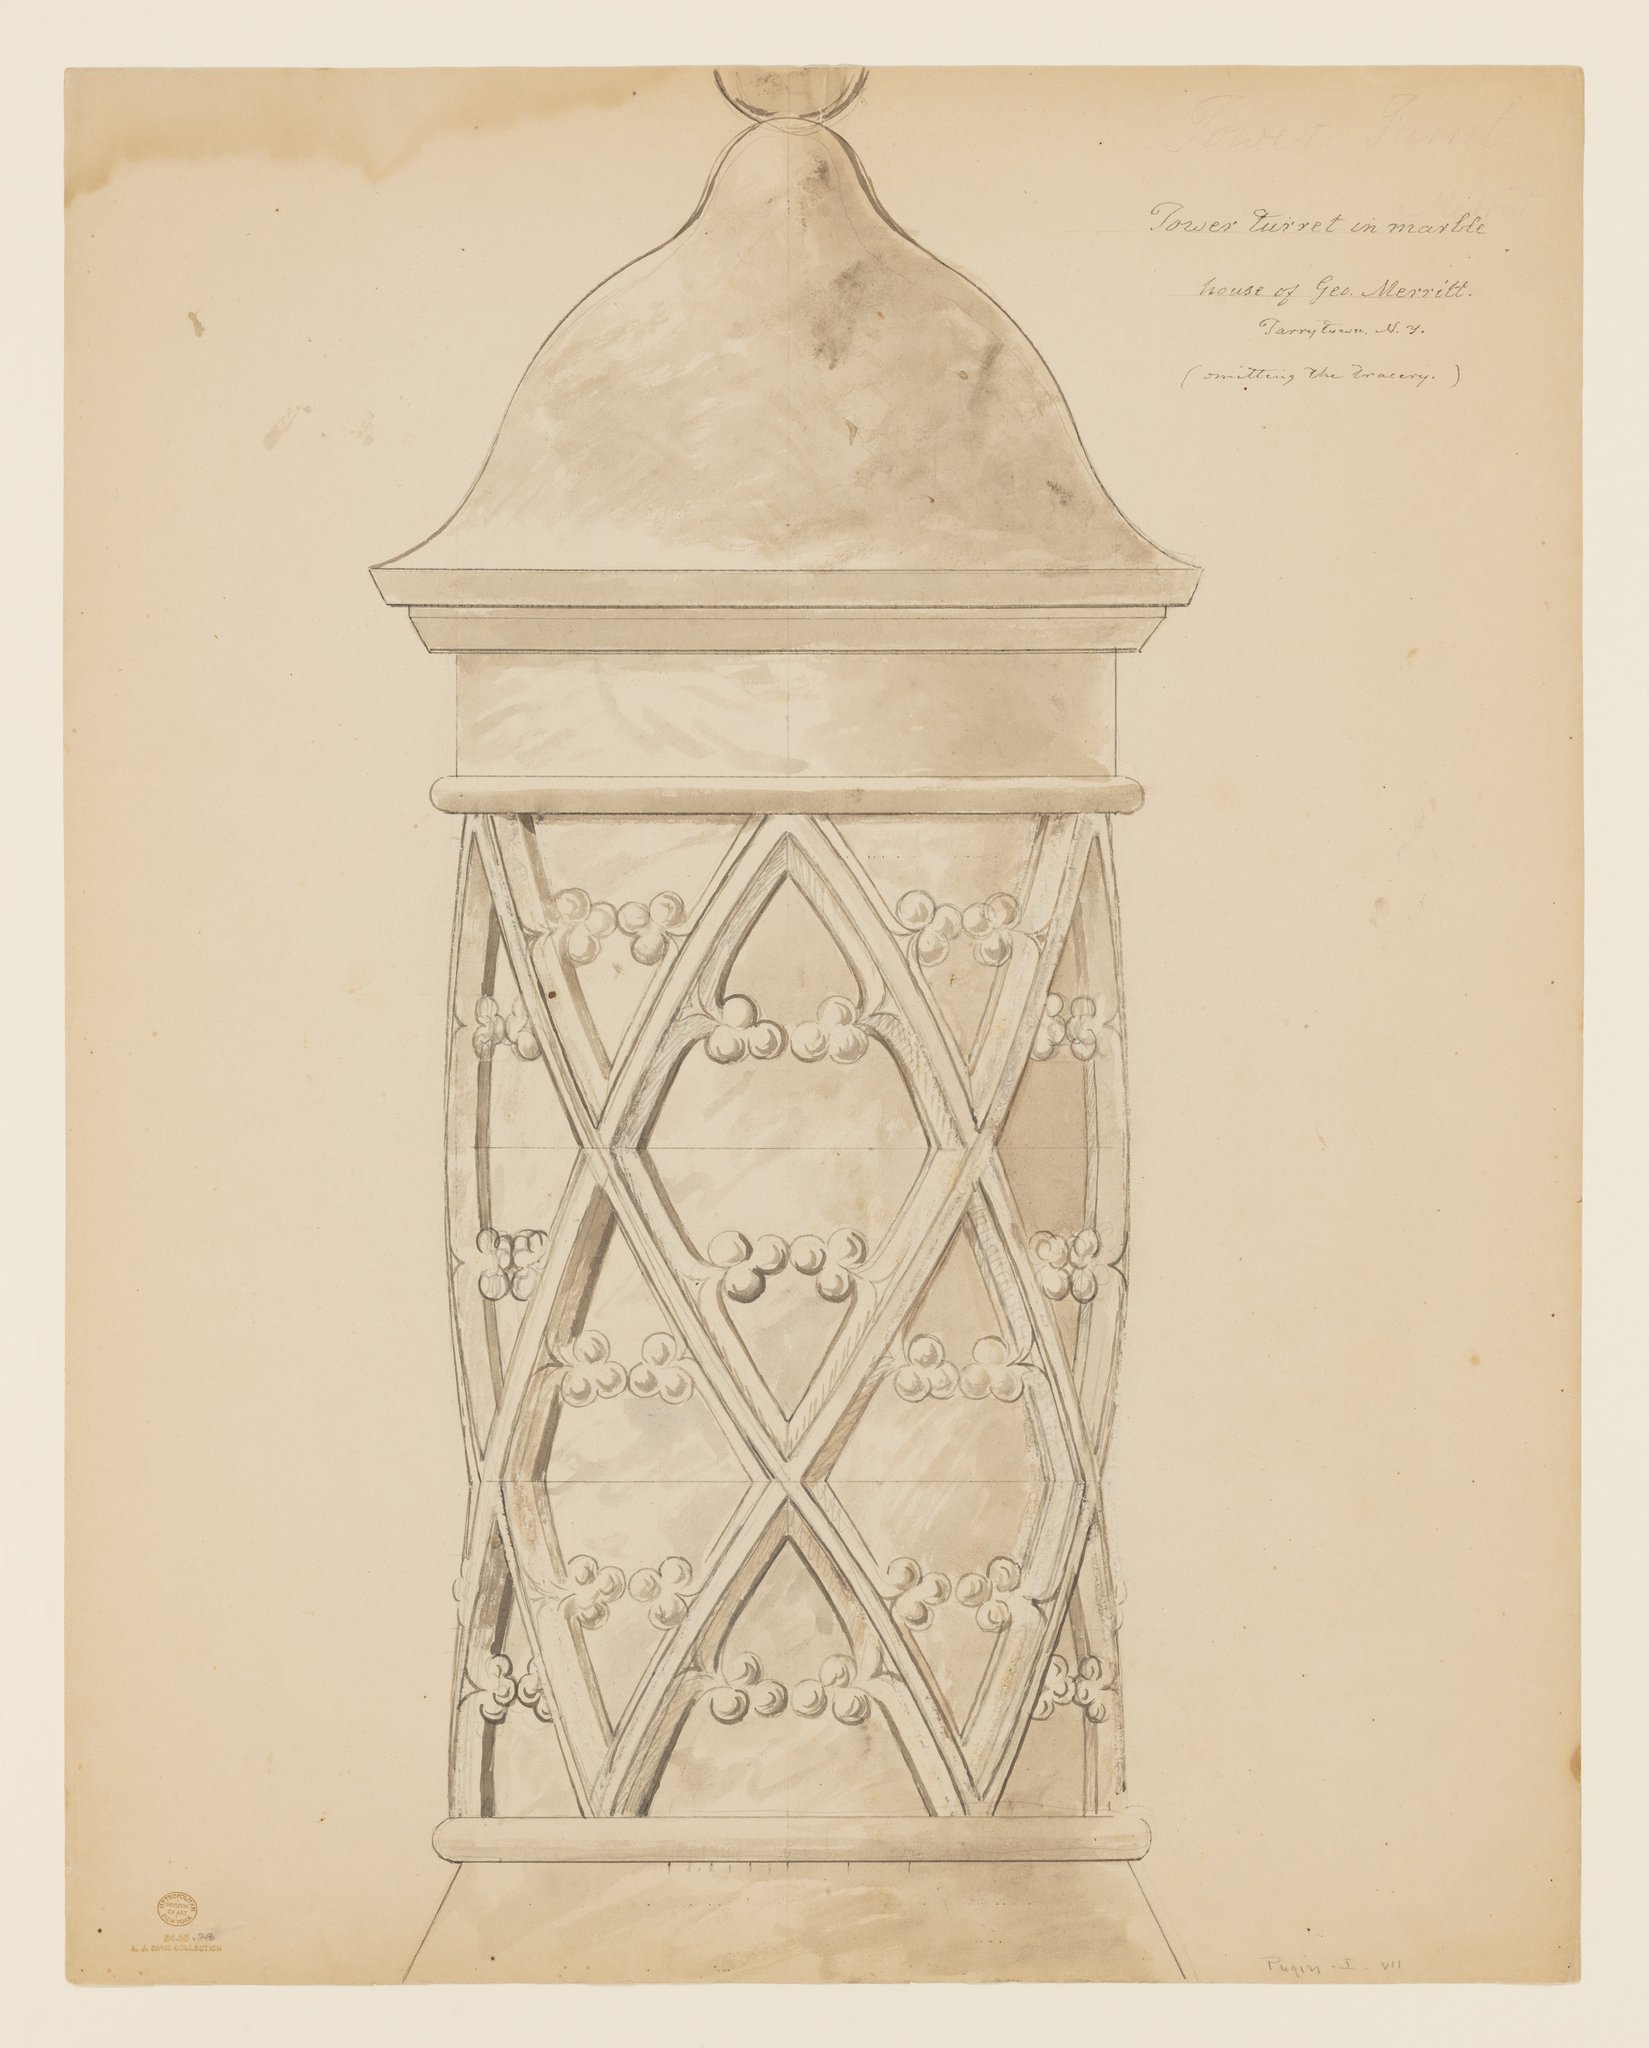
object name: drawing ornament architecture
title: Elevation of a Marble Tower Turret at Lyndhurst for George Merritt, Tarrytown, New York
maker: alexander jackson davis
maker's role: artist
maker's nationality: american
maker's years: 1803-1892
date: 1866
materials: graphite, watercolor